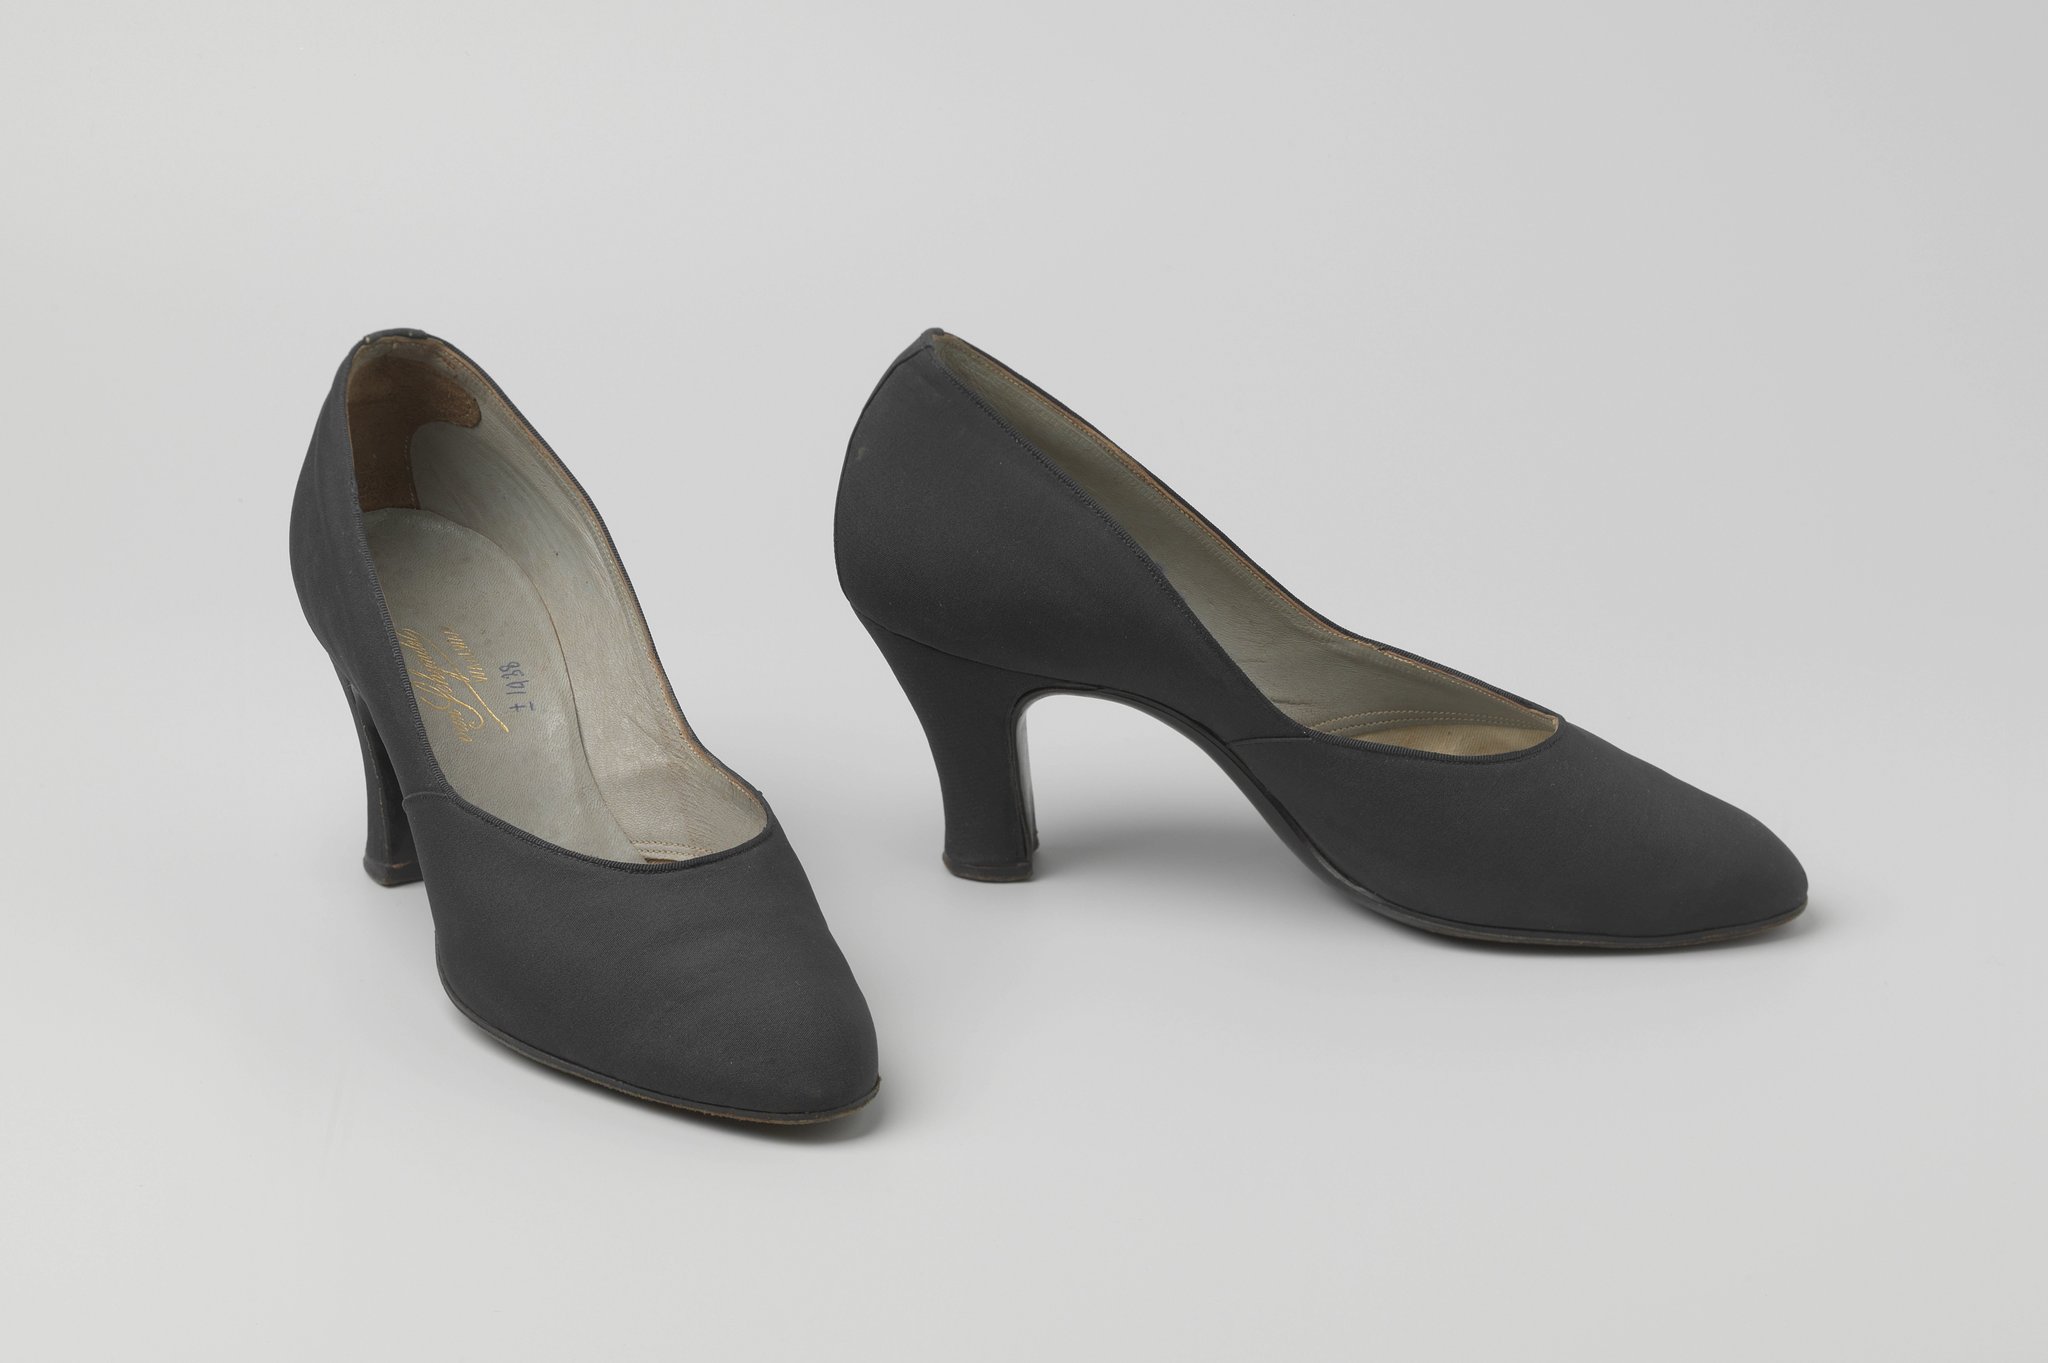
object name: womenswear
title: Pump van donkerblauwe ripszijde met hoge hak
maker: van schijndel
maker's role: schoenmaker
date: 1938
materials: cotton, leather, metal, silk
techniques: tanning, weave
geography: waalwijk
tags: amsterdam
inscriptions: size: ‘6’, company name: ‘van Schijndel // Waalwijk’, inscription: ‘5886 801 6 0’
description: Damesschoen van donkerblauwe ripszijde. Model: Afgeronde spitse neus, één voorblad en twee zijbladen. Over de naad waar de twee zijbladen bij elkaar komen op de hiel een band donkerblauwe ripszijde. De voorkant van de hoge hak loopt in een afgeronde hoek recht naar beneden. De zijkant en achterkant van de hak lopen schuin naar binnen waardoor de hak naar onder toe smaller wordt. De hak is bekleed met donkerblauwe ripszijde. Leren achterlapje met vijf spijkers aan de hak vastgeslagen en leren zool. Voorblad gevoerd met crèmekleurig geribd katoen. Zijbladen gevoerd met grijs leer. In de hiel een stuk T-vormig bruin geruwd leer. De binnenzool is van grijs leer. Schachtrand afgebiesd met donkerblauw ripsband.